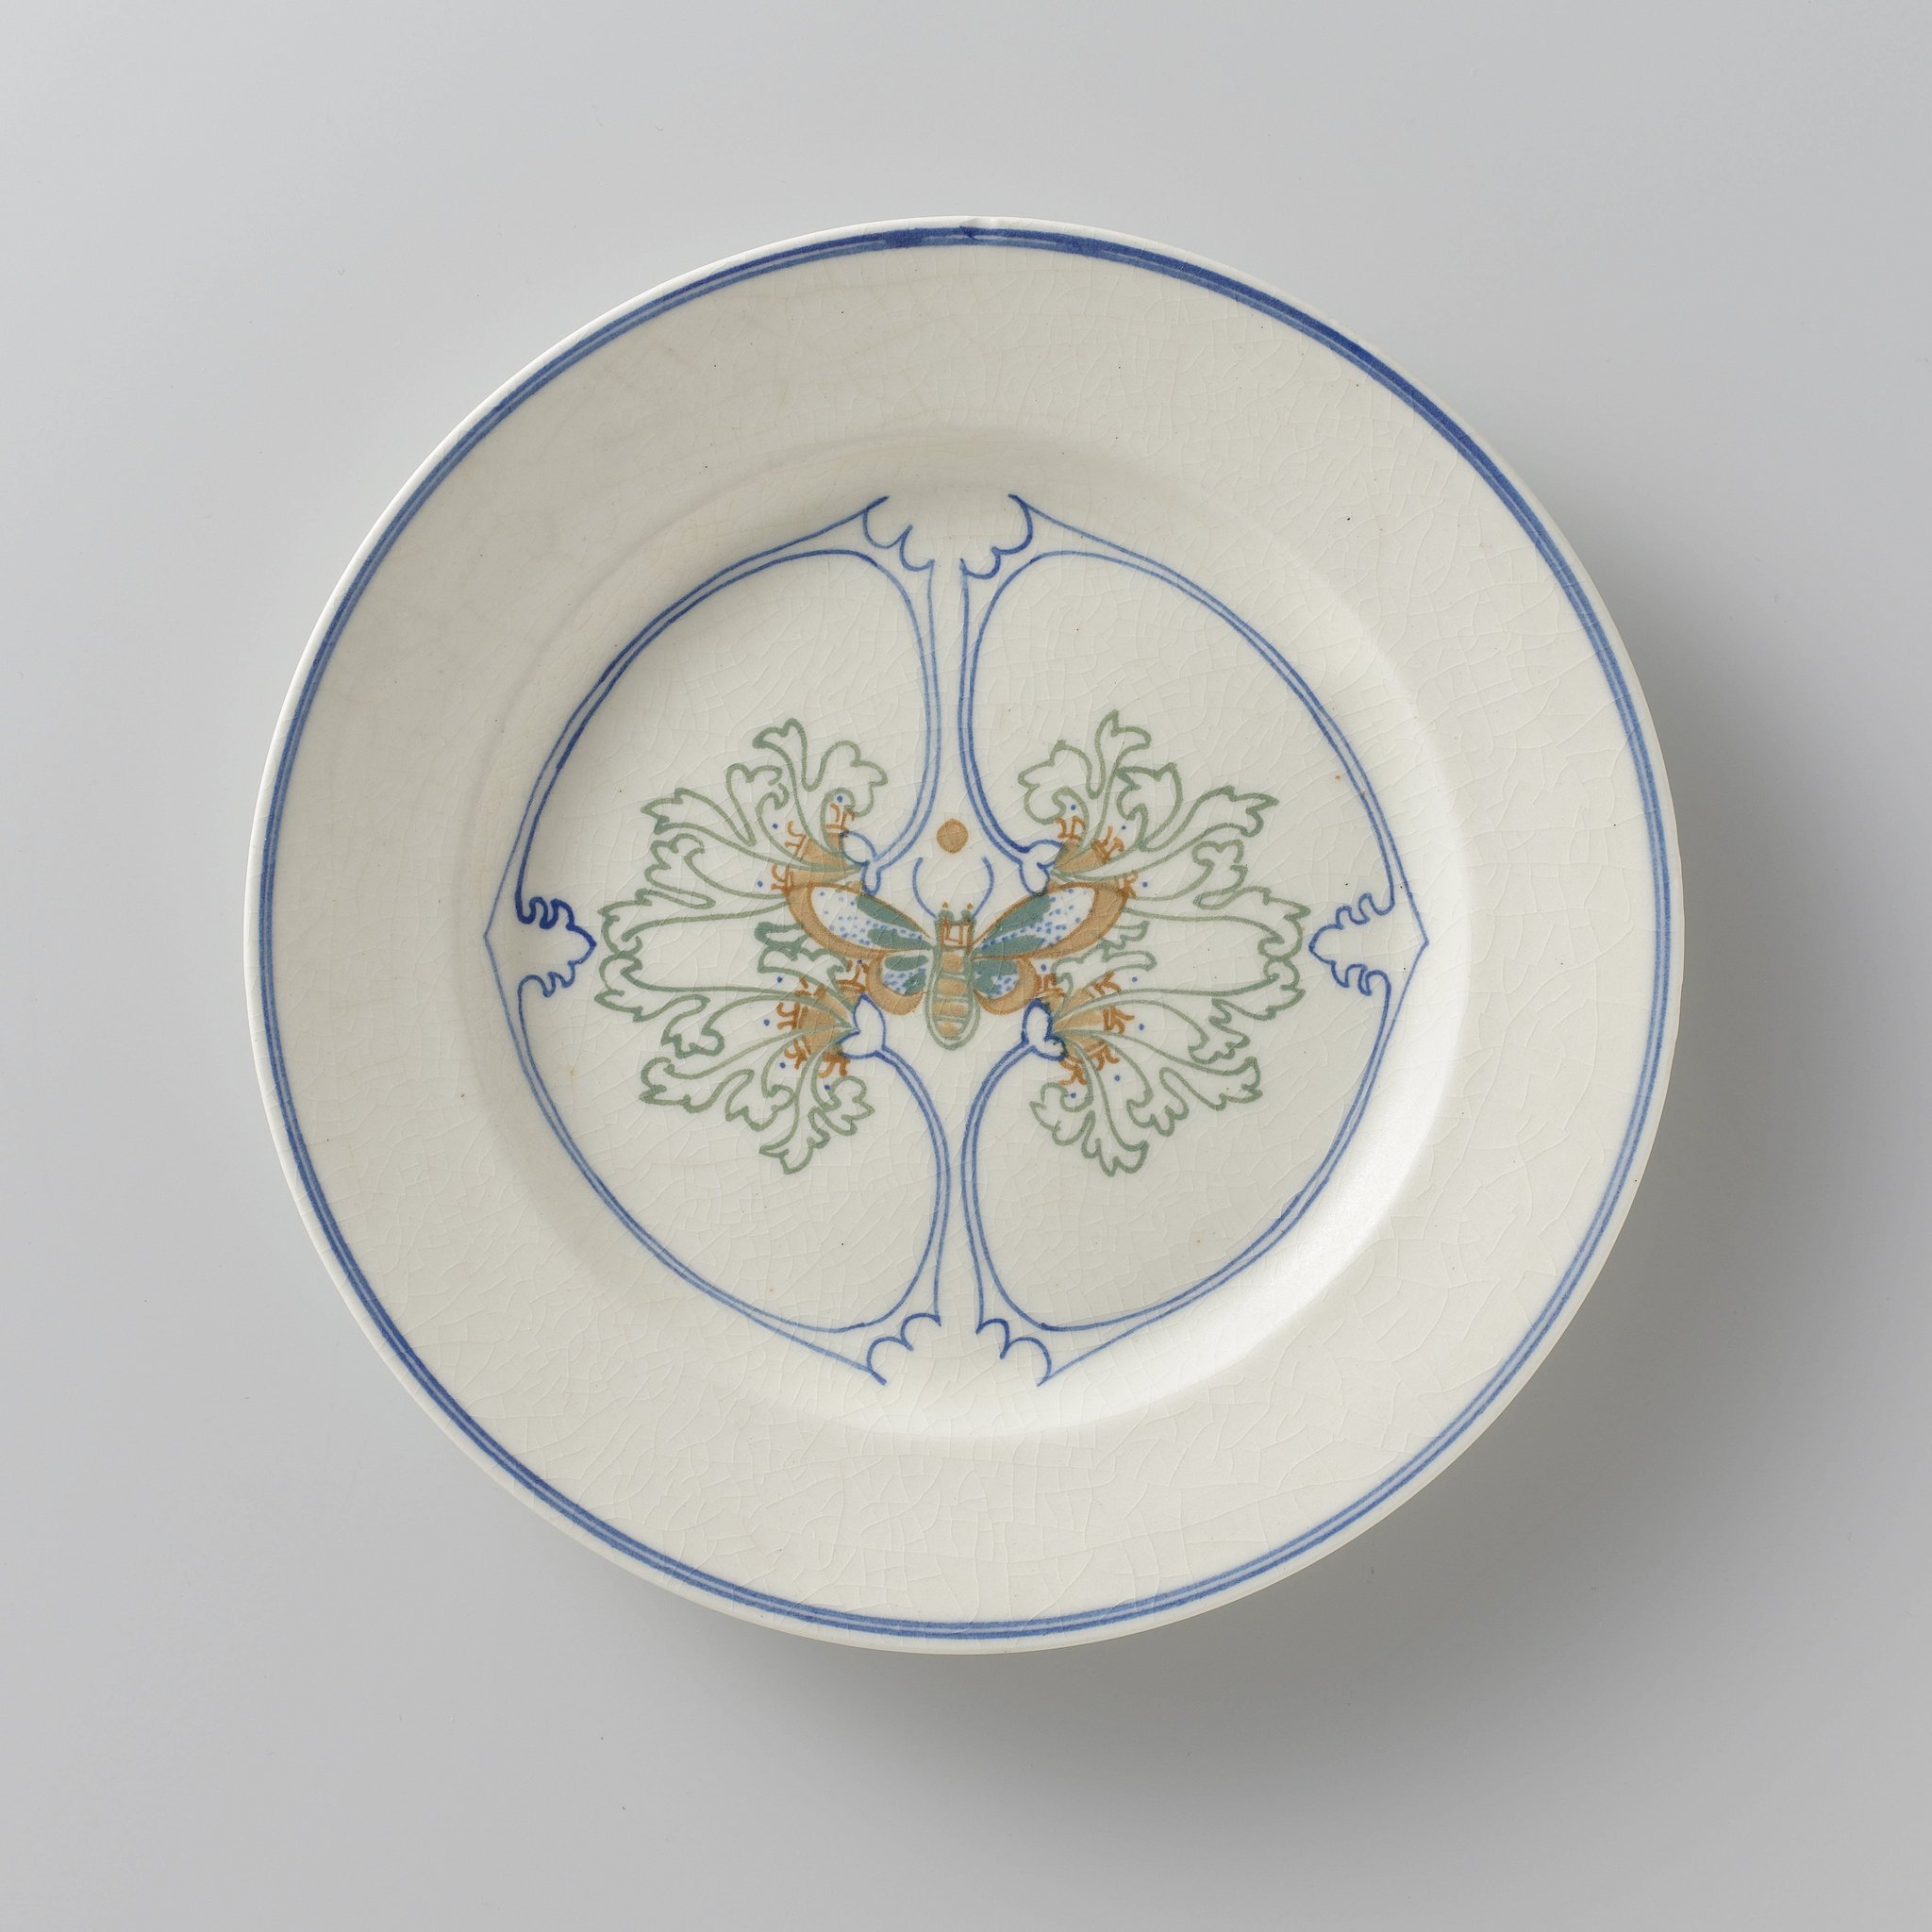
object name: plate dish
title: Bord van aardewerk met decor van een vlinder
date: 1910-1915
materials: earthenware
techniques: painted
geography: arnhem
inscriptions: mark: ‘Een haan waaronder ARNHEM in zwart en een teken in blauw.’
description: Bord van aardewerk, beschilderd in blauw, groen en oranje met een Art Nouveau-decor met een vlinder in het midden, binnen blauwe lijnen. Ook blauwe lijnen op de rand.